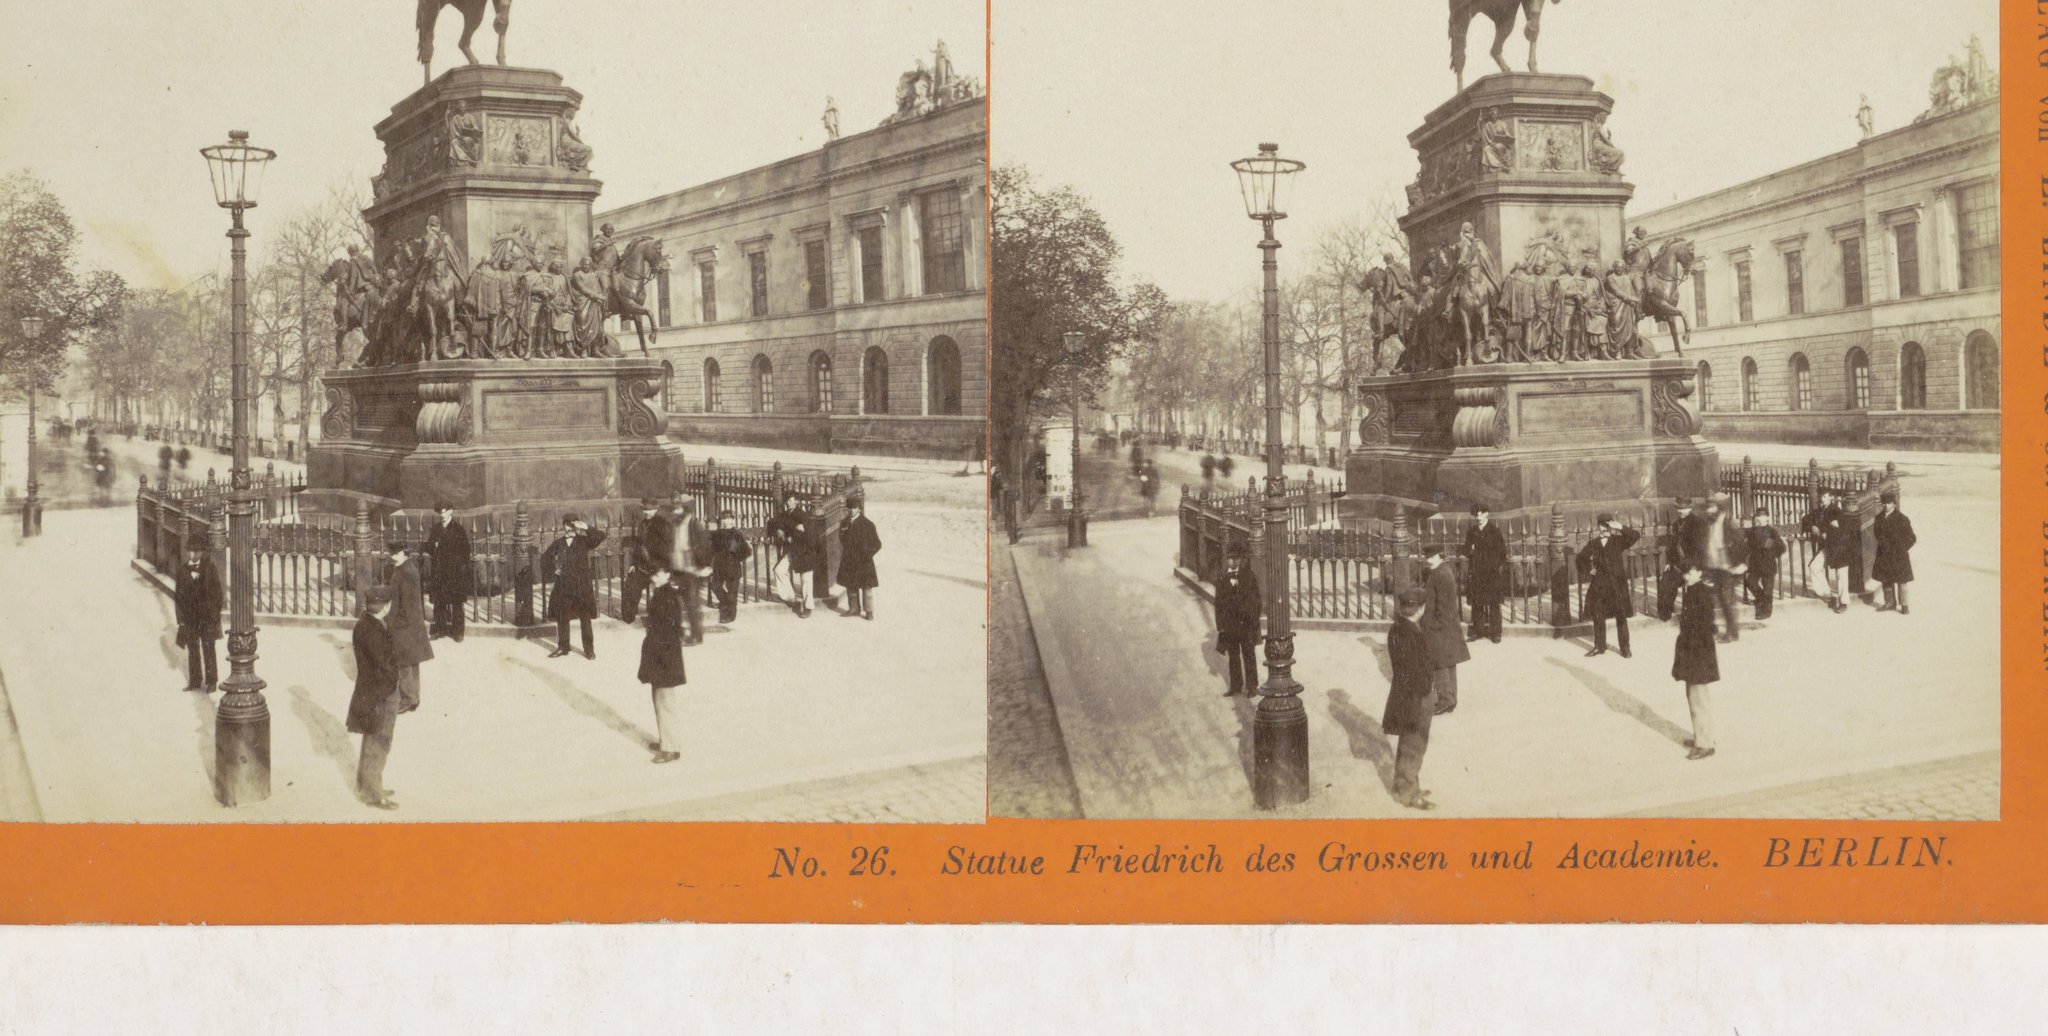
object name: stereograph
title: Statue Friedrich des Grossen und Academie. Berlin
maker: johann friedrich stiehm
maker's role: fotograaf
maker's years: 1826-1902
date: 1868-1870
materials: cardboard, paper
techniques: albumen print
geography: unter den linden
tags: berlin, frederick ii (king of prussia), monument, statue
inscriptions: number: ‘No. 26.’